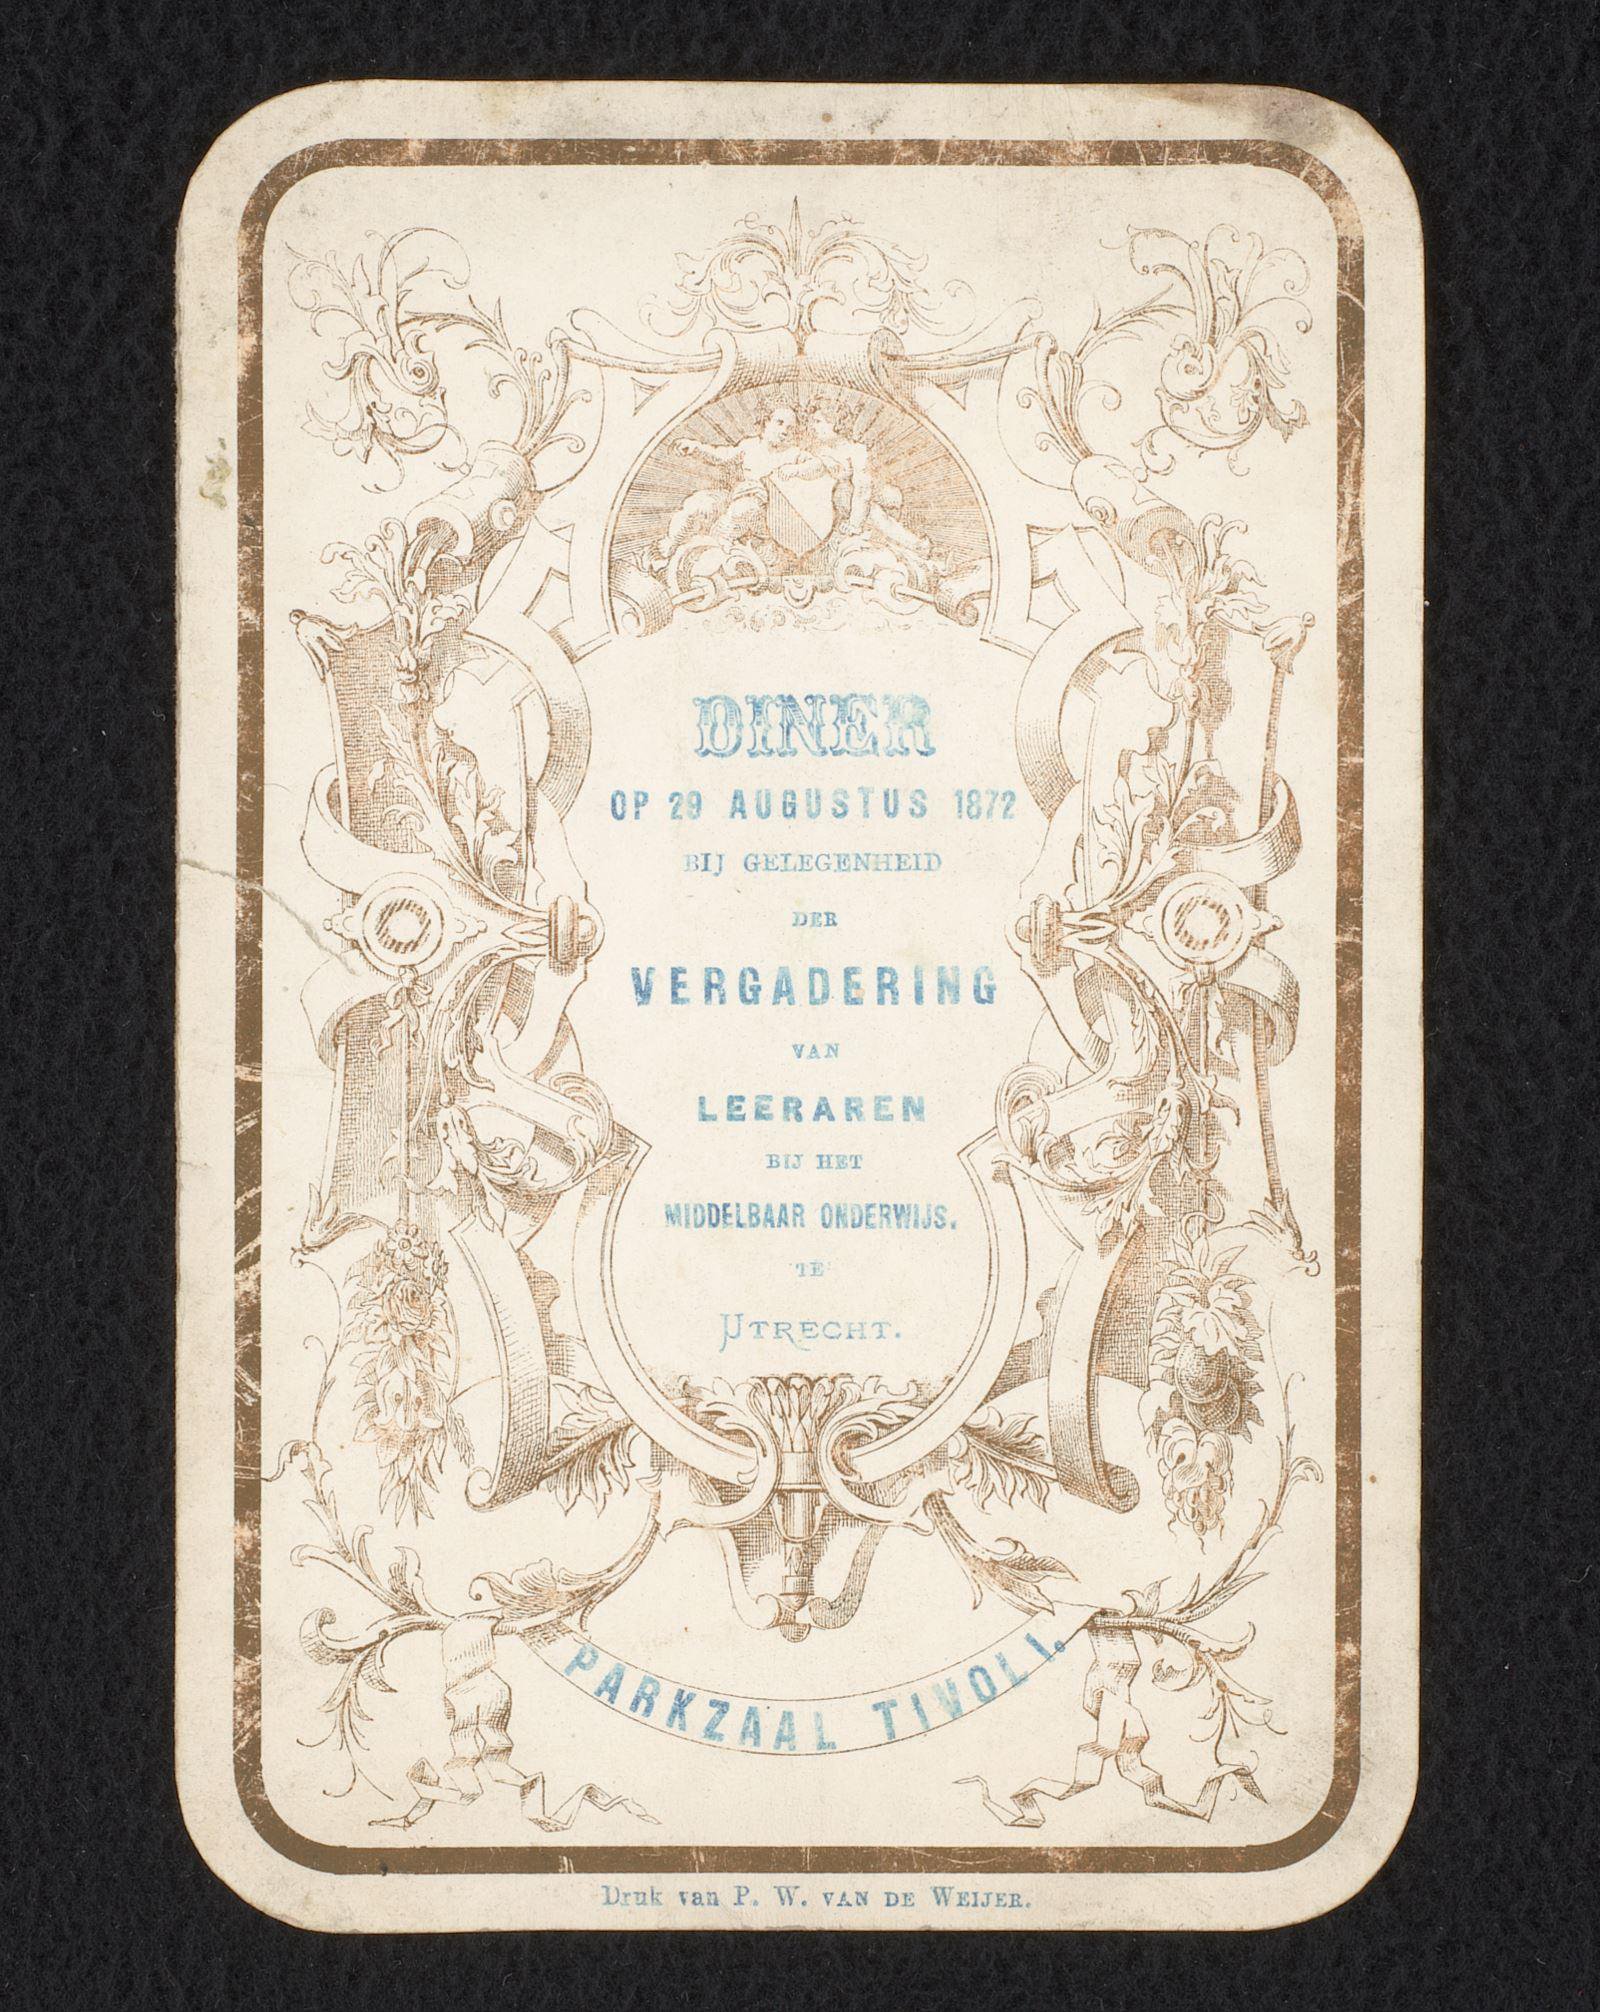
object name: print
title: Menukaart voor het diner bij de 'Vergadering van Leeraren bij het Middelbaar Onderwijs' in Utrecht op 29 augustus 1872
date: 1872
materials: paper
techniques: lithograph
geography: utrecht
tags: utrecht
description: Een decoratief kader met bovenaan twee putti met het stadswapen van Utrecht. Daaronder de tekst van de uitnodiging voor het diner, dat op 29 augustus 1872 plaatvond in de Parkzaal Tivoli in Utrecht. Op de achterzijde het menu.